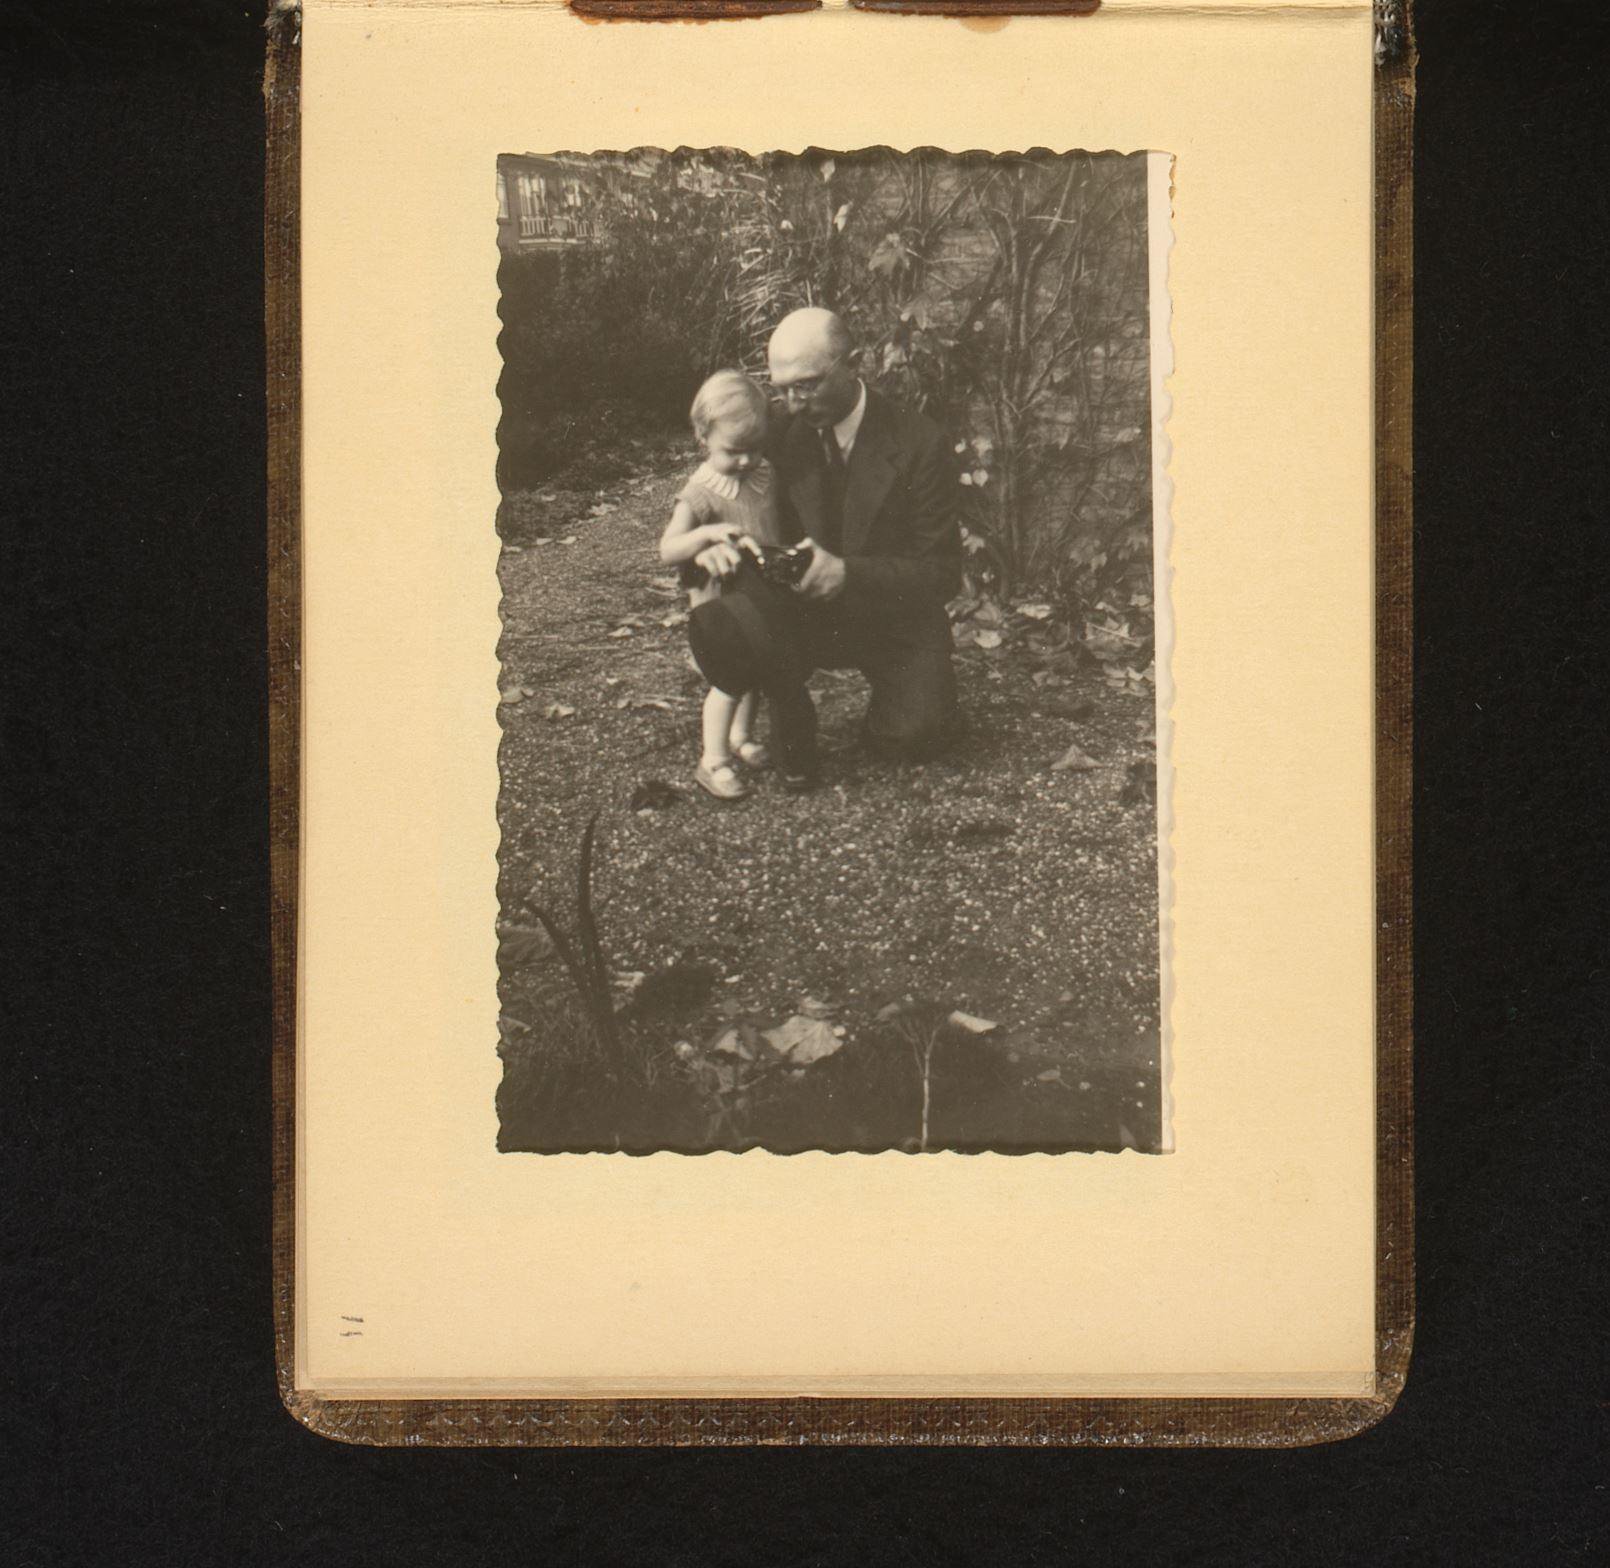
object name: photograph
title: Kind en man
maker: Anonymous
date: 1911-1938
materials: cardboard, photographic support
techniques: gelatin silver print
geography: deventer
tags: family life at home, deventer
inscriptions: inscription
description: Albumblad met een foto van een kind met een knielende man. Onderdeel van het familiealbum 1938-1939.